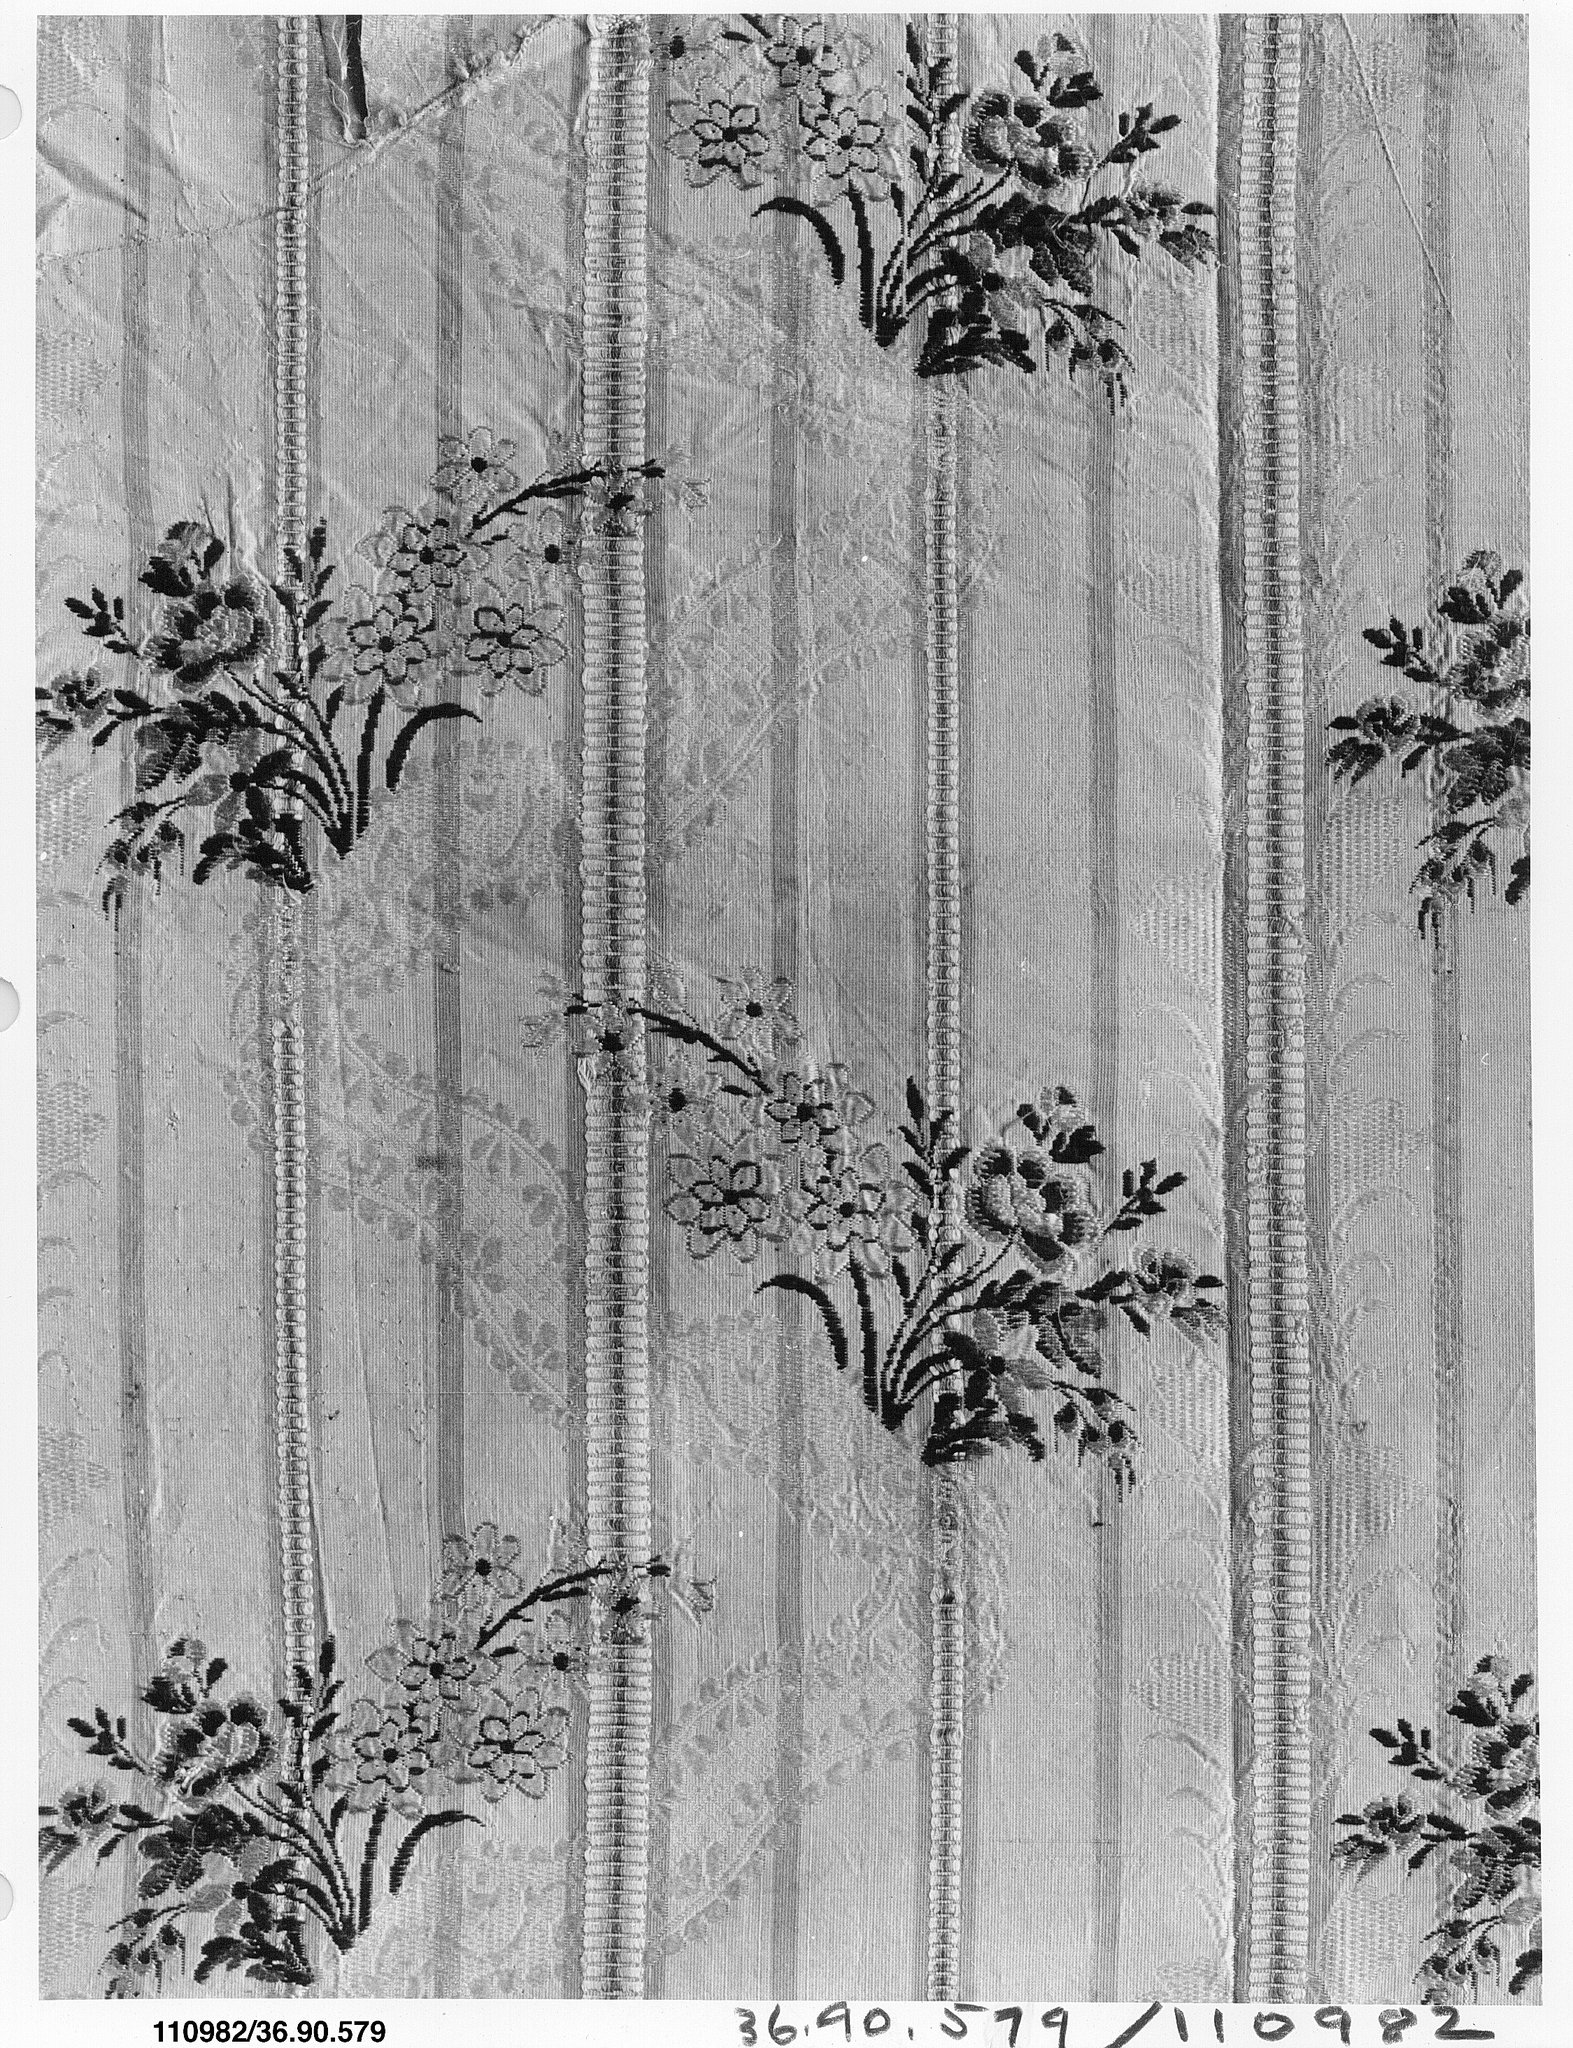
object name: piece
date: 1760-1770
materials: silk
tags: flowers